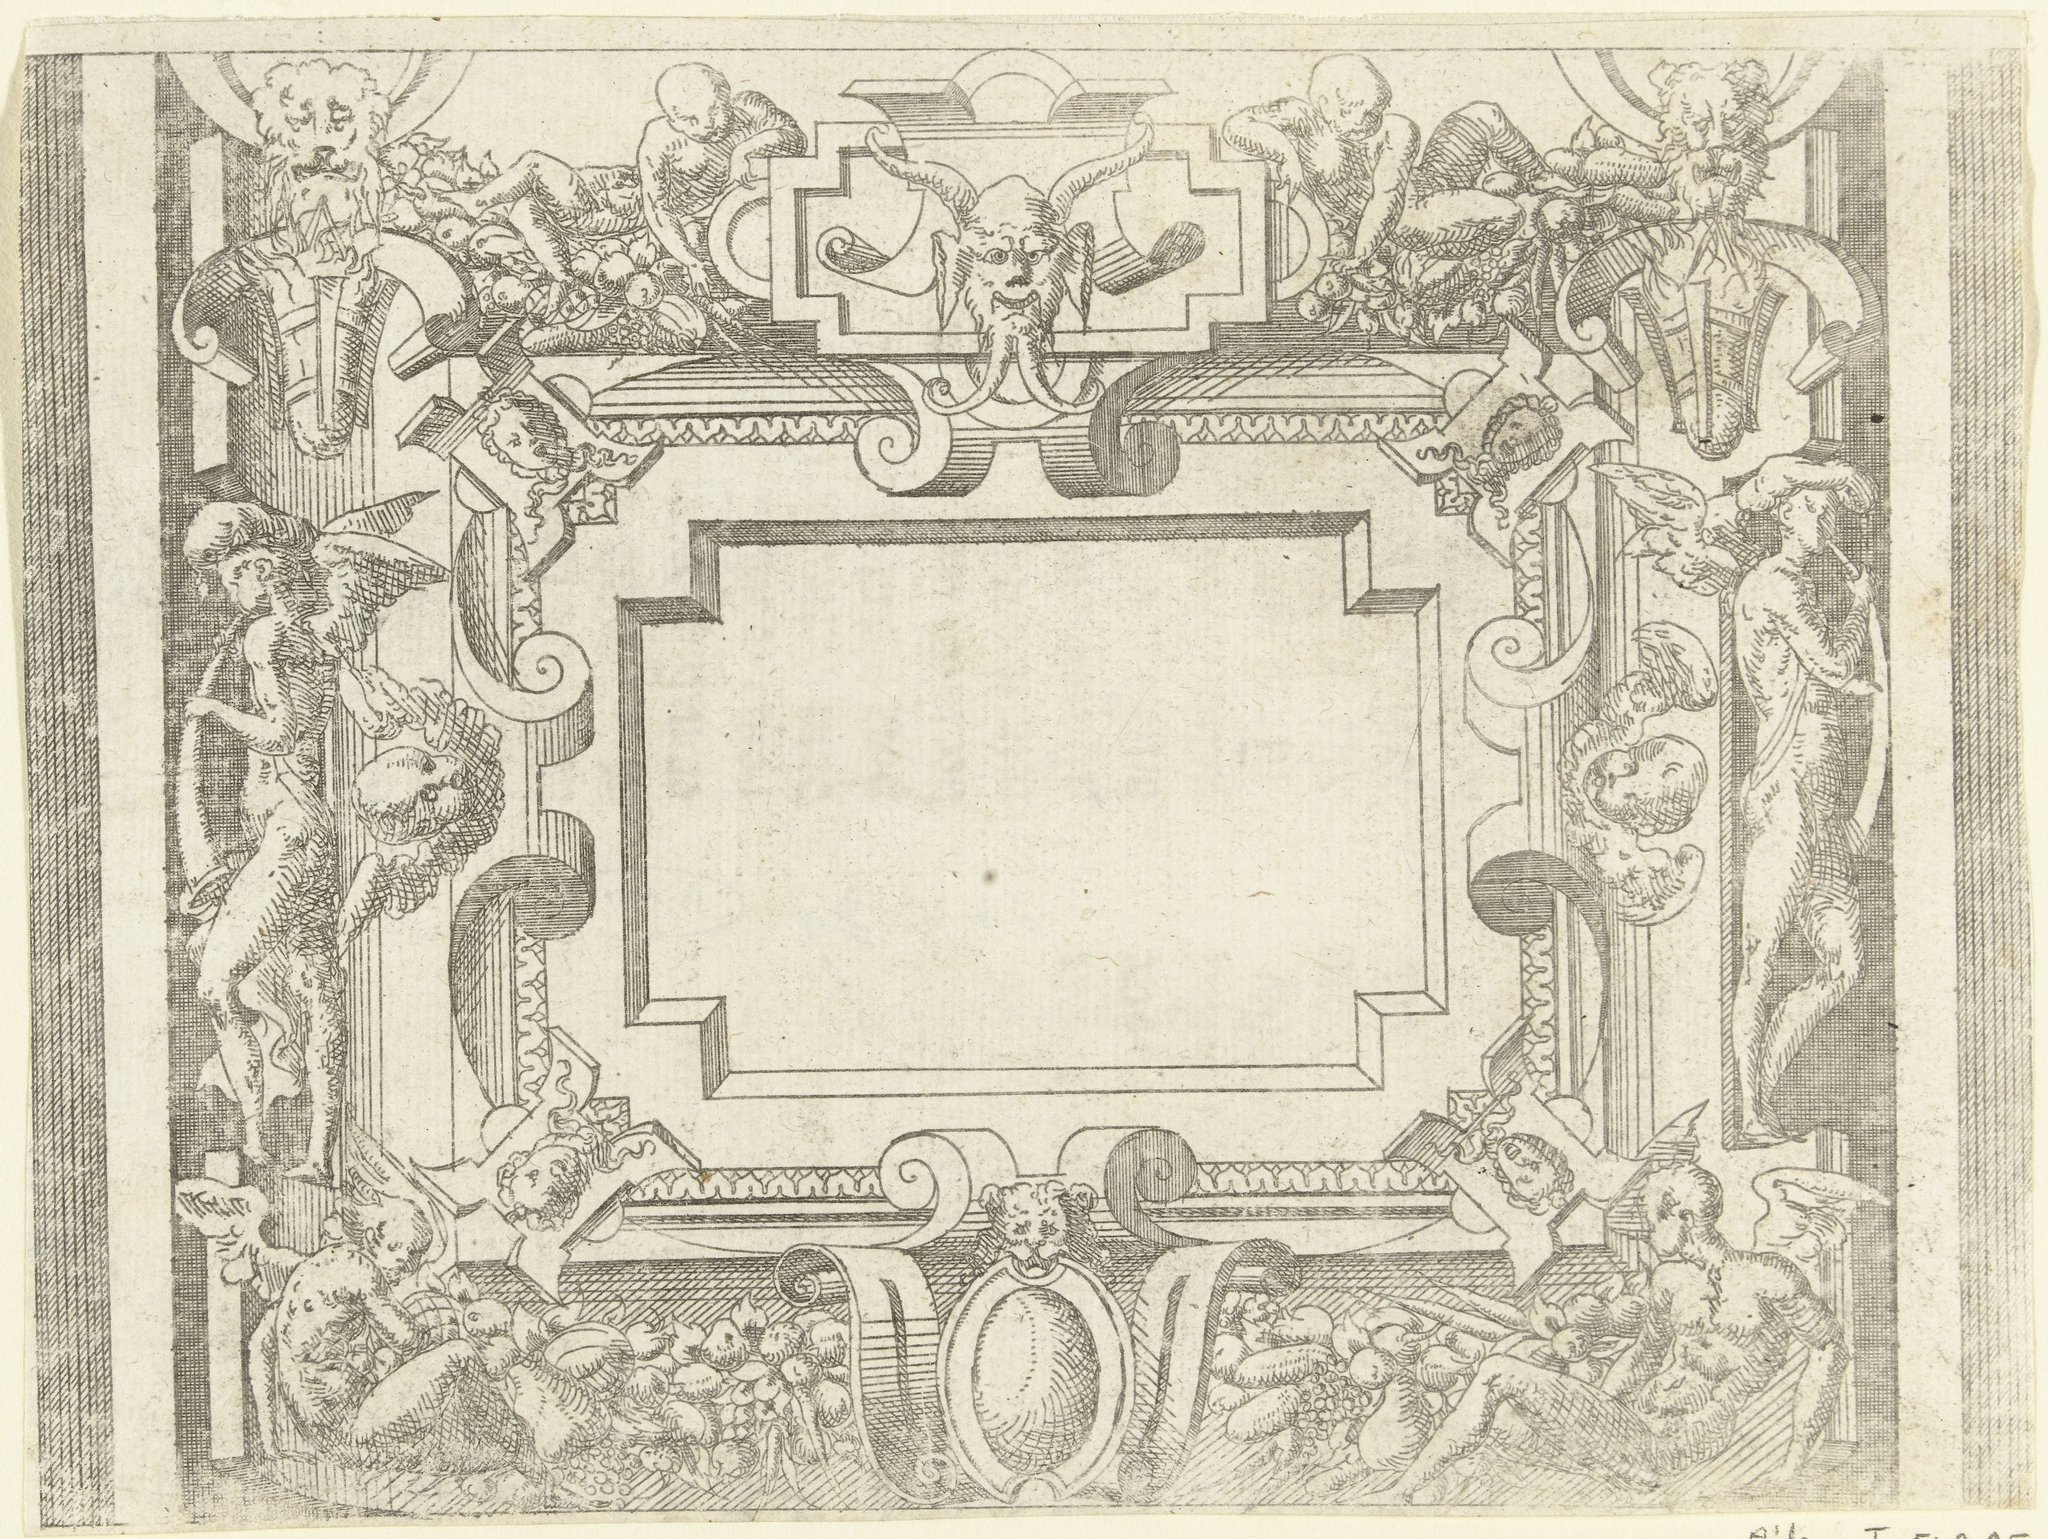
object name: print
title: Rechthoekige cartouche met midden boven een mascaron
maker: Anonymous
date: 1520-1584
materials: paper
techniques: etching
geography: france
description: Links en rechts staat een engel met een baret op te blazen op een bazuin. Uit serie van 32 bladen. De cartouches zijn deels ontleend aan de prenten van Antonio Fantuzzi naar de decoratie van de Galerie van François 1er door Giovanni Battista Rosso. De serie staat ook bekend onder de titel Petits cartouches de Fontainebleau.